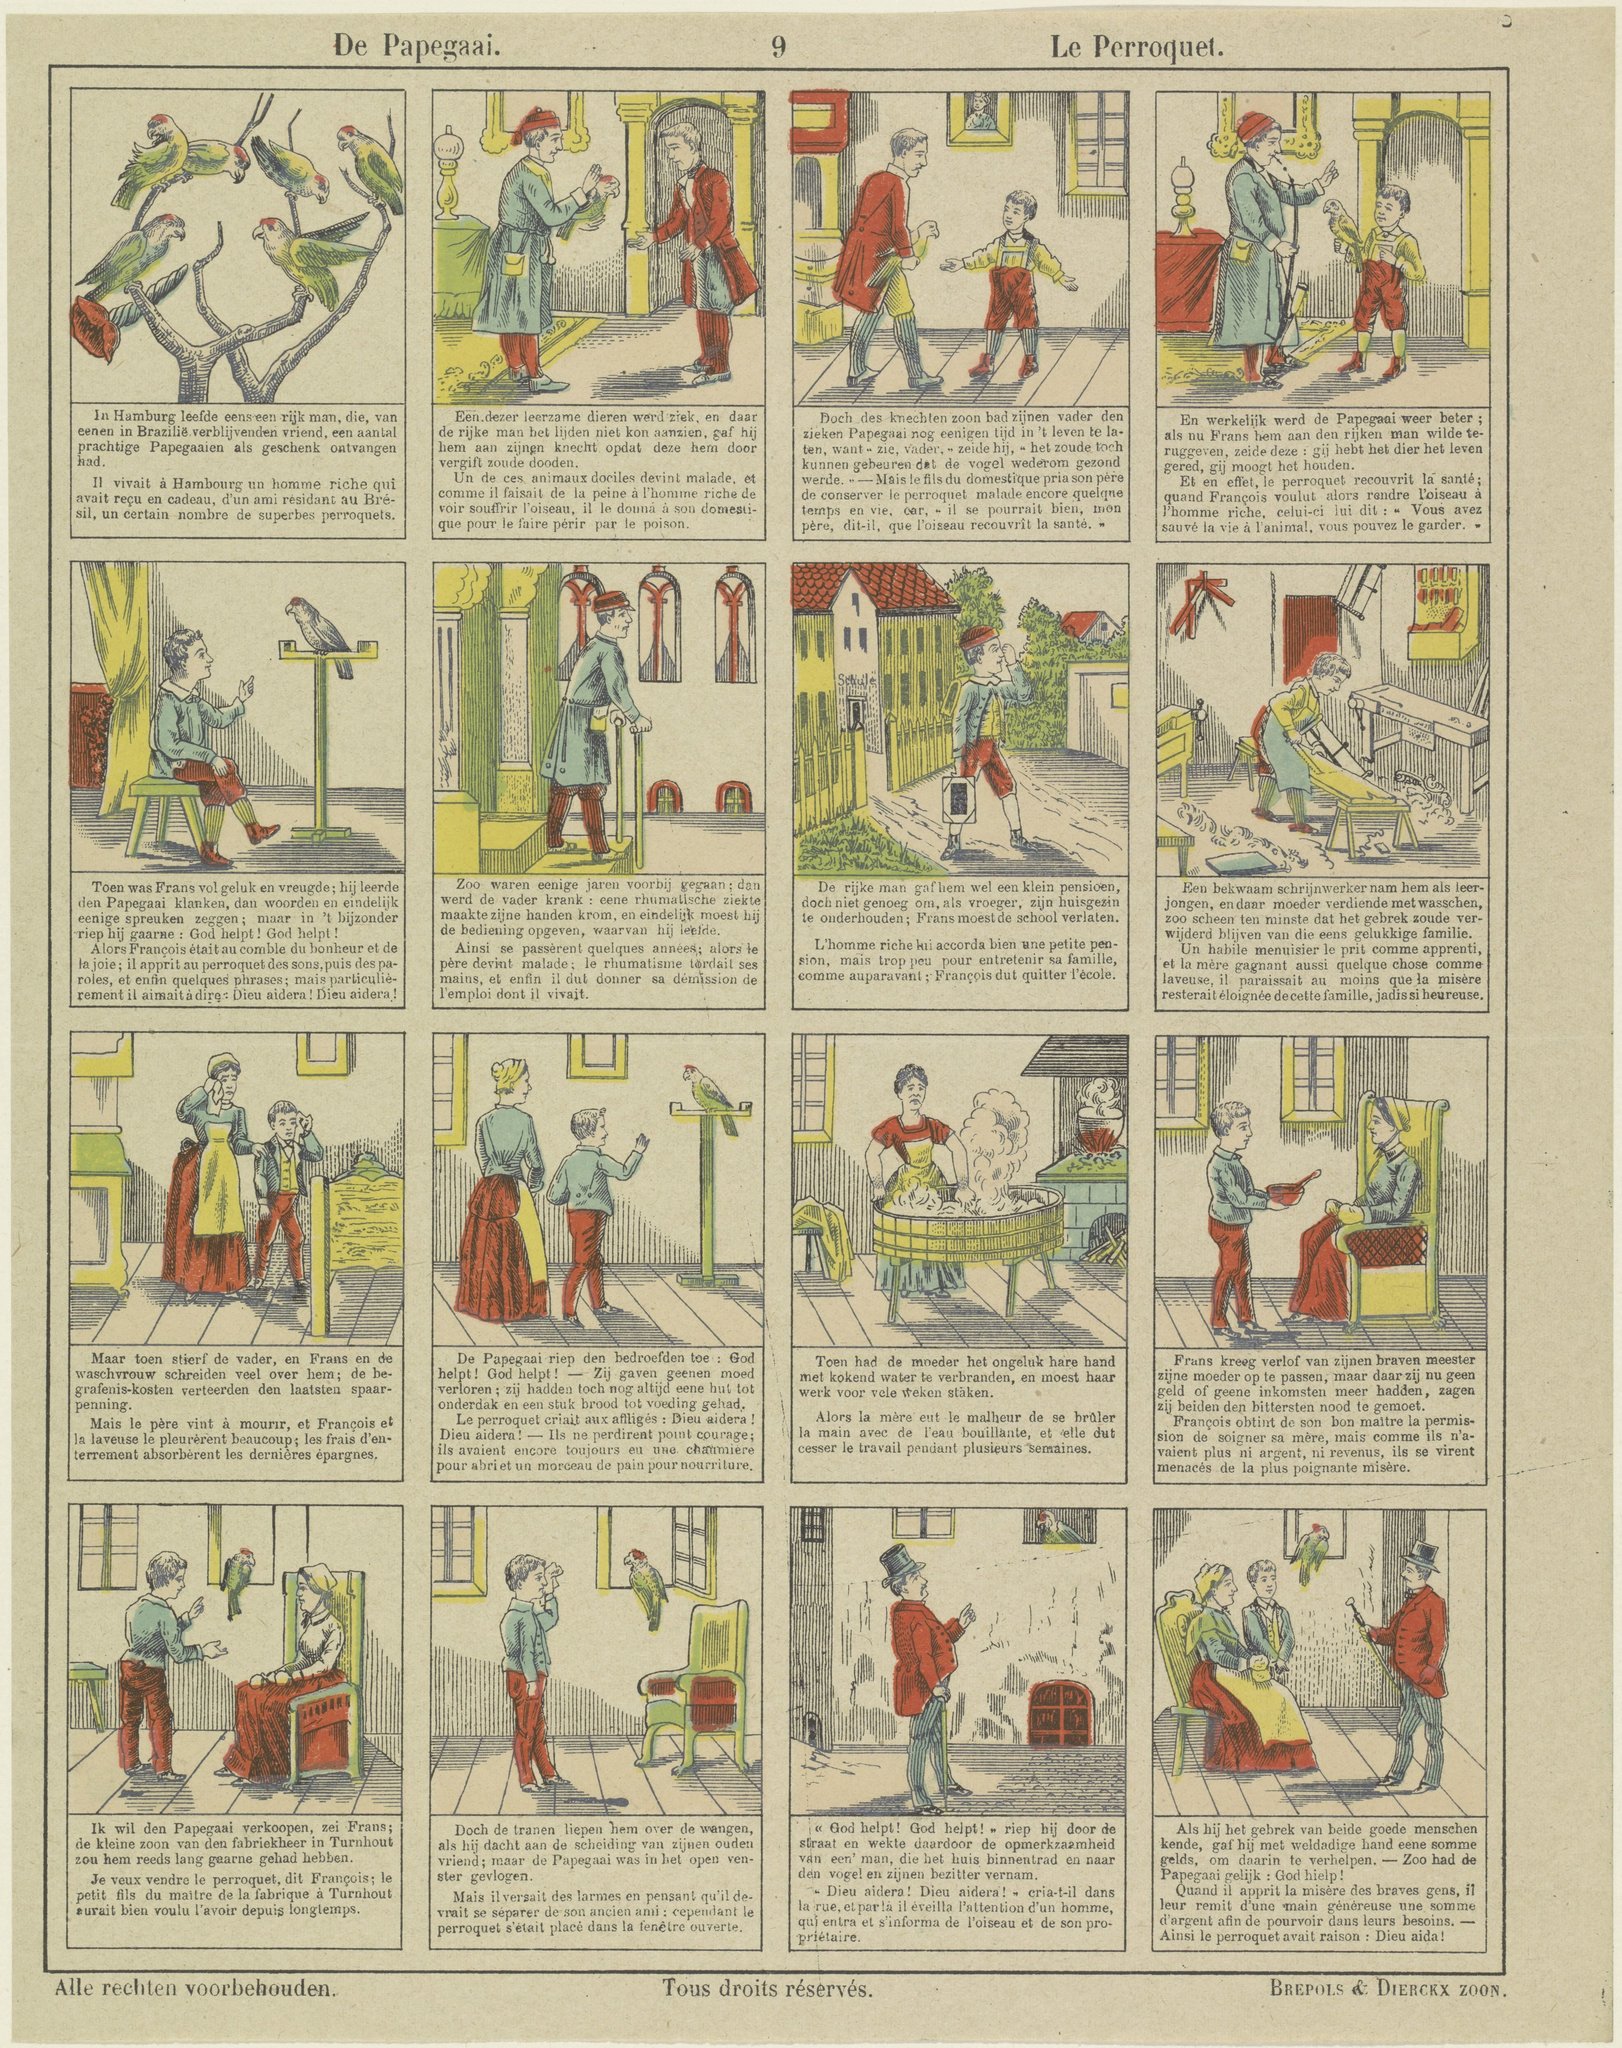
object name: popular print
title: De papegaai / Le perroquet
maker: Anonymous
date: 1833-1911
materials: paper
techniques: lithograph, letterpress printing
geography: turnhout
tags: ornamental birds: parrot, tales and fairy tales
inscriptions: collector's mark: Lugt 2760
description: Blad met 16 voorstellingen uit het sprookje over het jongetje Frans die zijn papegaai verkoopt om van het geld te kunnen leven. Onder elke afbeelding een onderschrift in het Nederlands en in het Frans. Genummerd midden boven: 9.